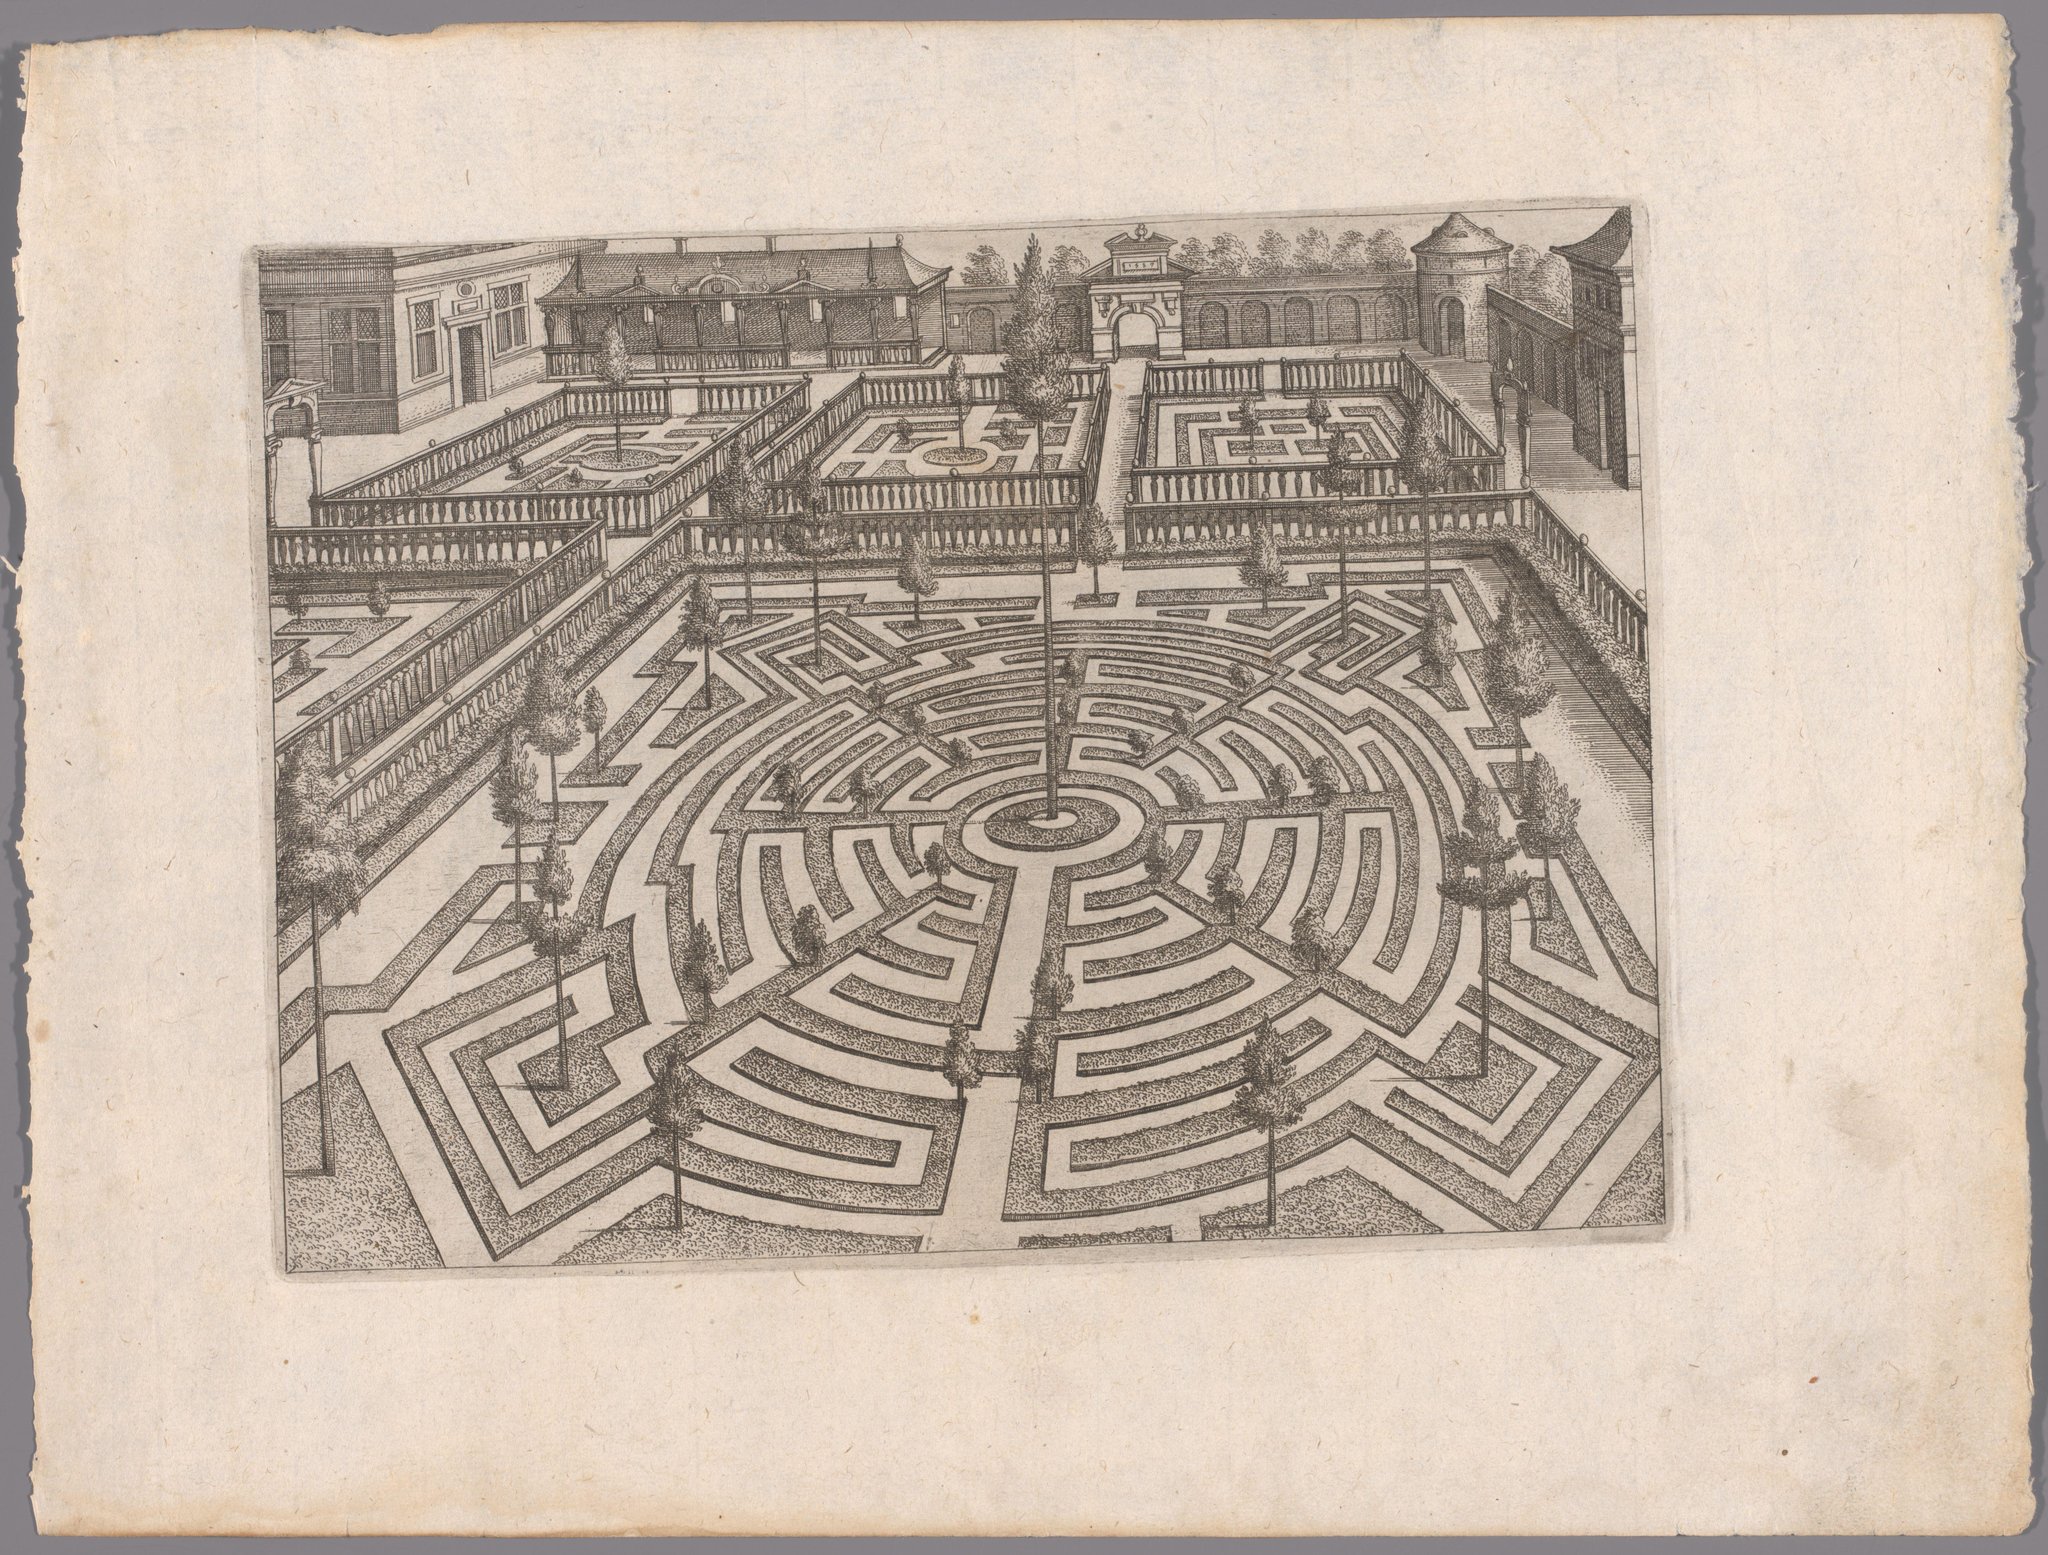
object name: ornament print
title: Tuinen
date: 1587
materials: paper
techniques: etching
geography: antwerp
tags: garden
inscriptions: collector's mark: Lugt 2228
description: Deel van een ontmanteld album waarvan RP-P-2013-1-54-1 t/m -37, RP-P-2013-1-55-1 en -2 en RP-P-2013-1-63 t/m 67 deel waren.